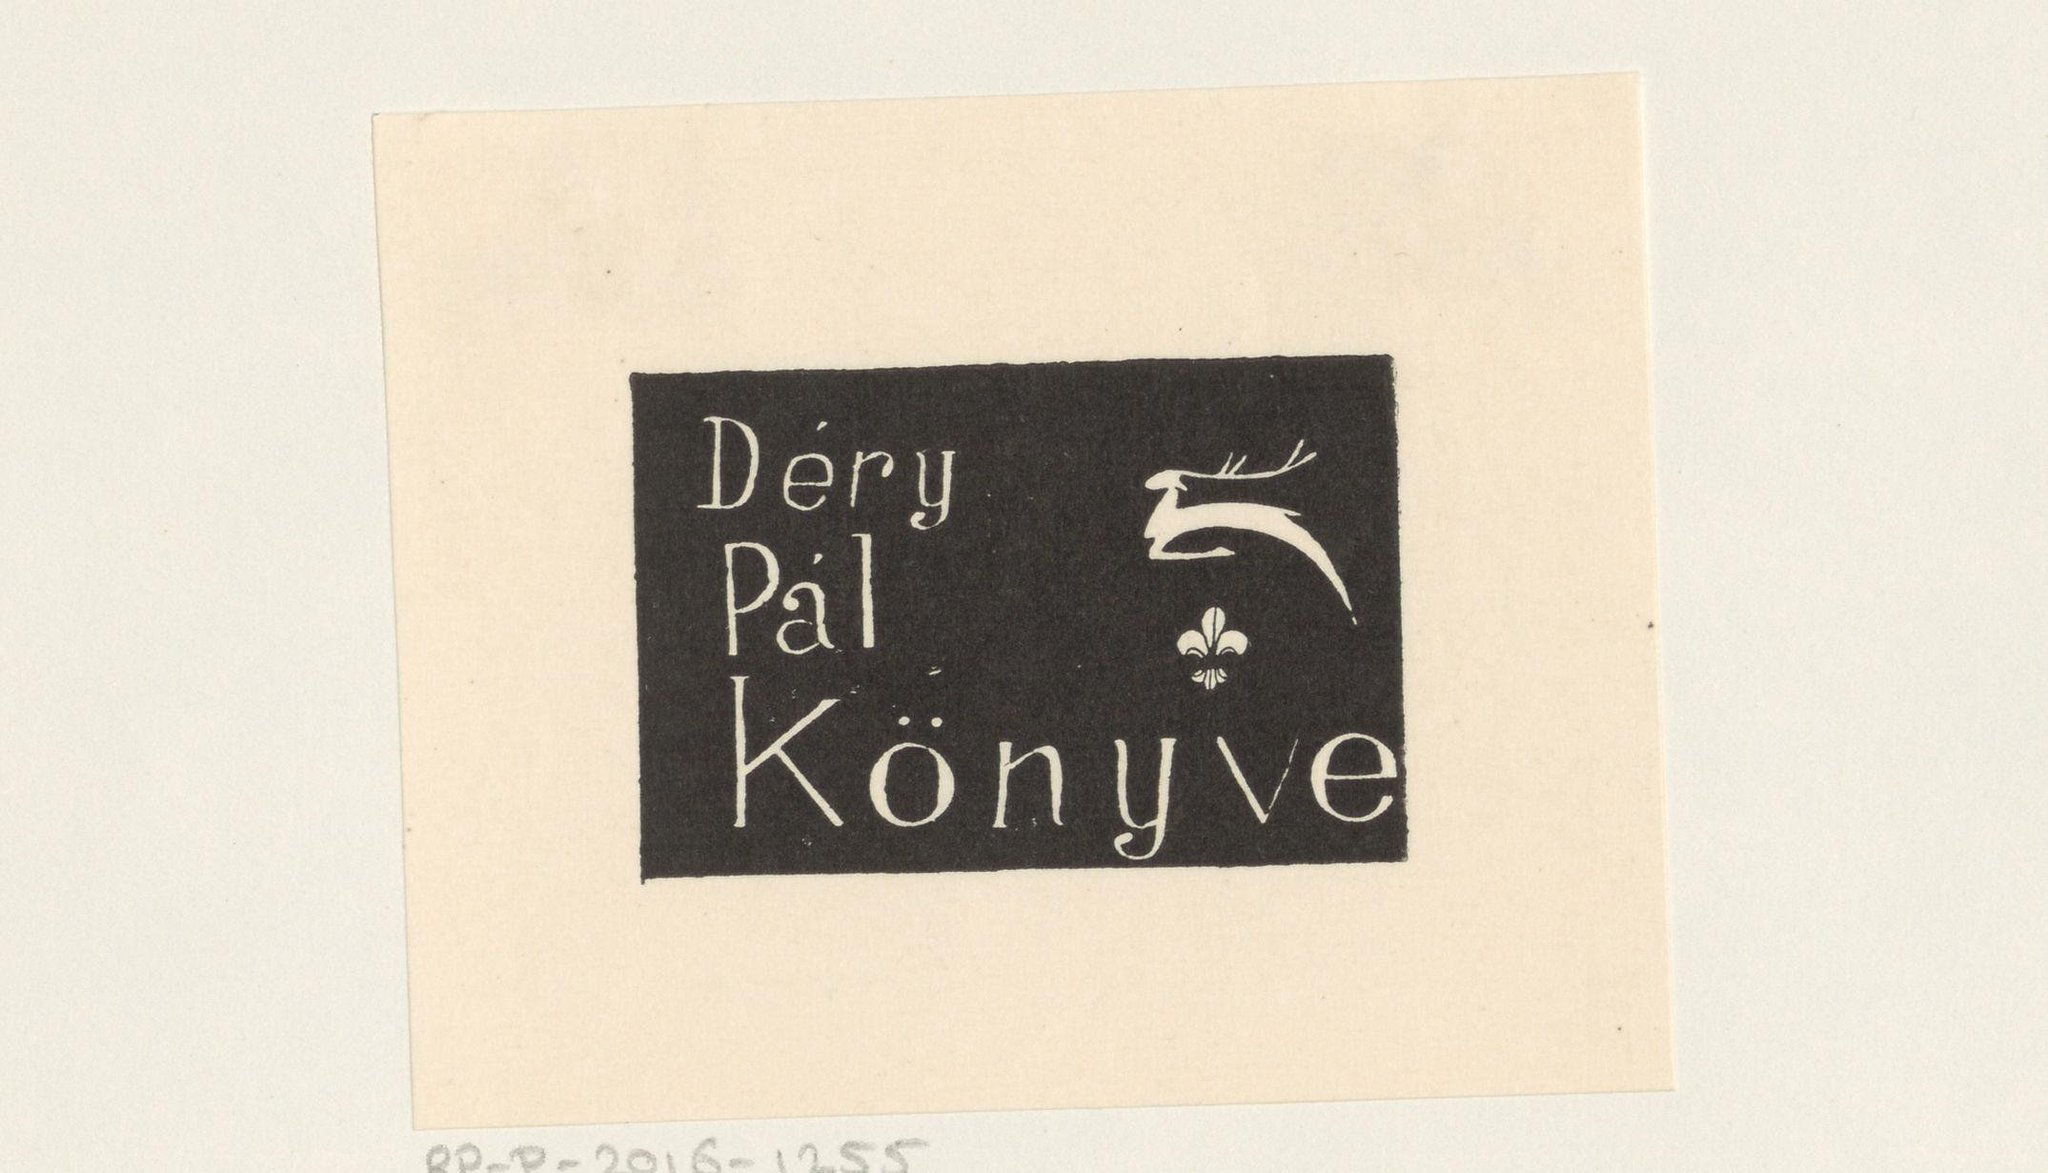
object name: bookplate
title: Ex libris van Déry Pál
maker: pál déry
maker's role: print maker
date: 1934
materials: paper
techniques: woodcut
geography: hungary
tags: pál déry, hoofed animals: stag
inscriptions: workshop stamp: ‘Ipse fecit / 1934’